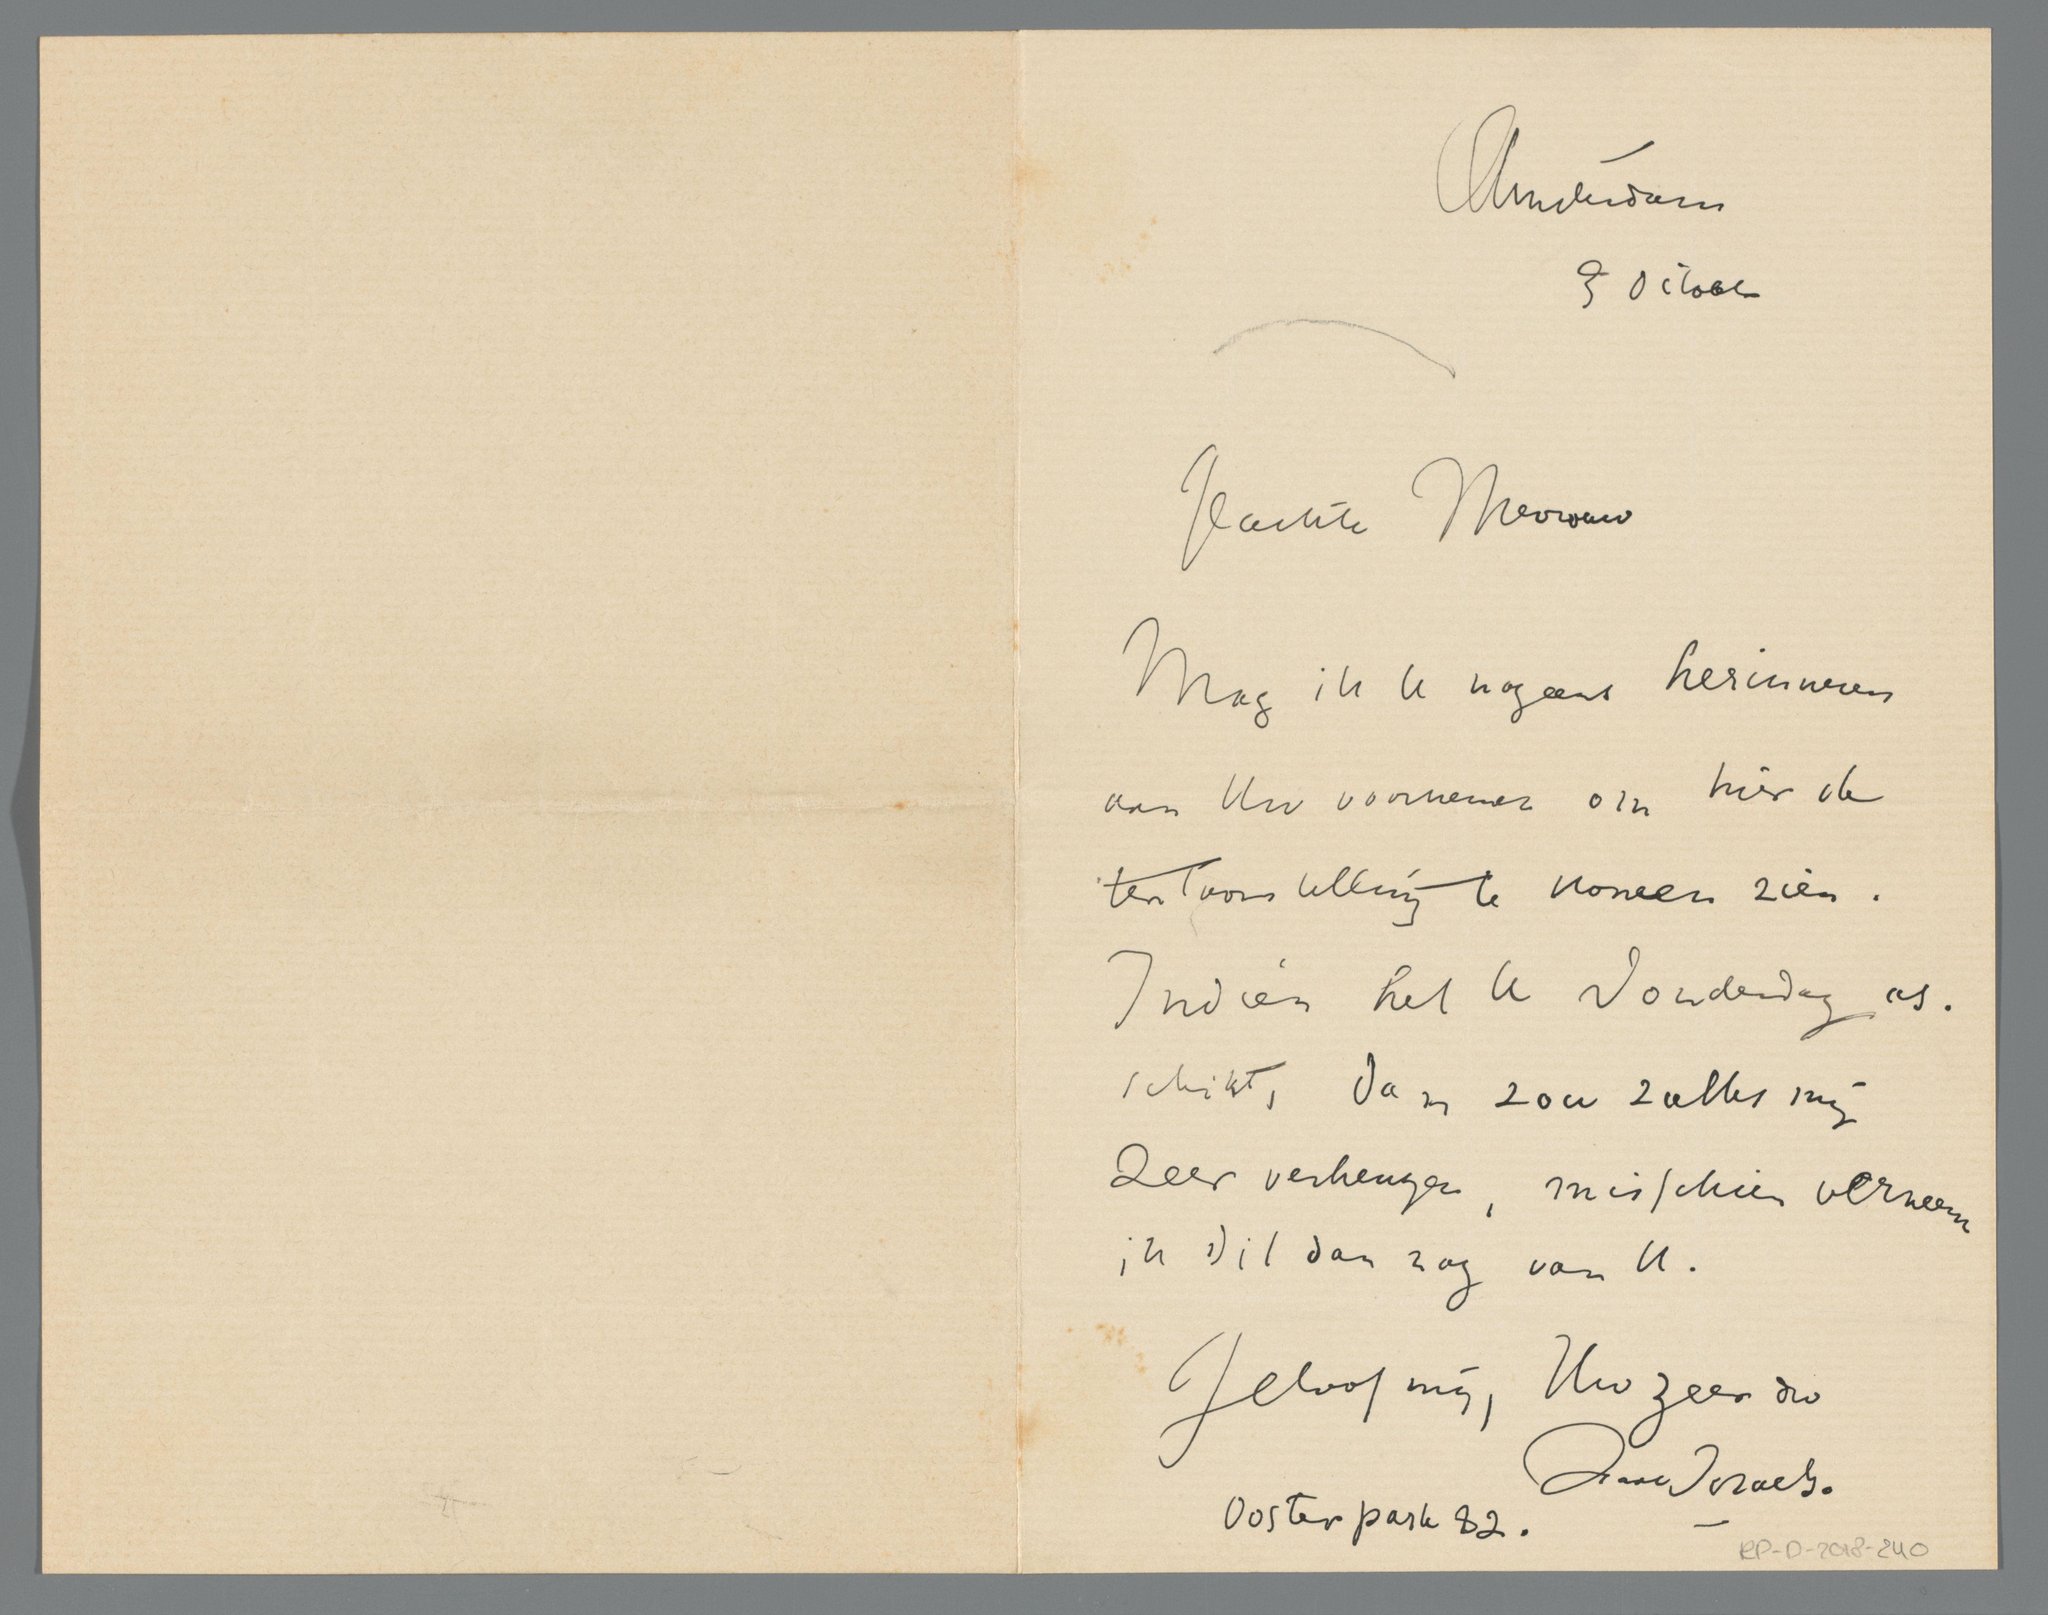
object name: letter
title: Brief aan Jeannette Bouman-Stuyling de Lange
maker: isaac israels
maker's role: draughtsman, painter, print maker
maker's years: 1865-1934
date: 1898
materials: ink, paper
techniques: pen, writing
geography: amsterdam